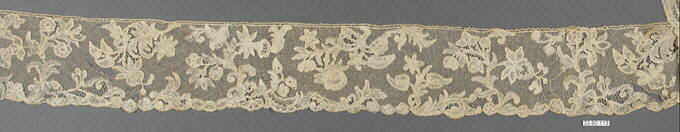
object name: edging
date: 1734-1766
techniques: lace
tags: flowers